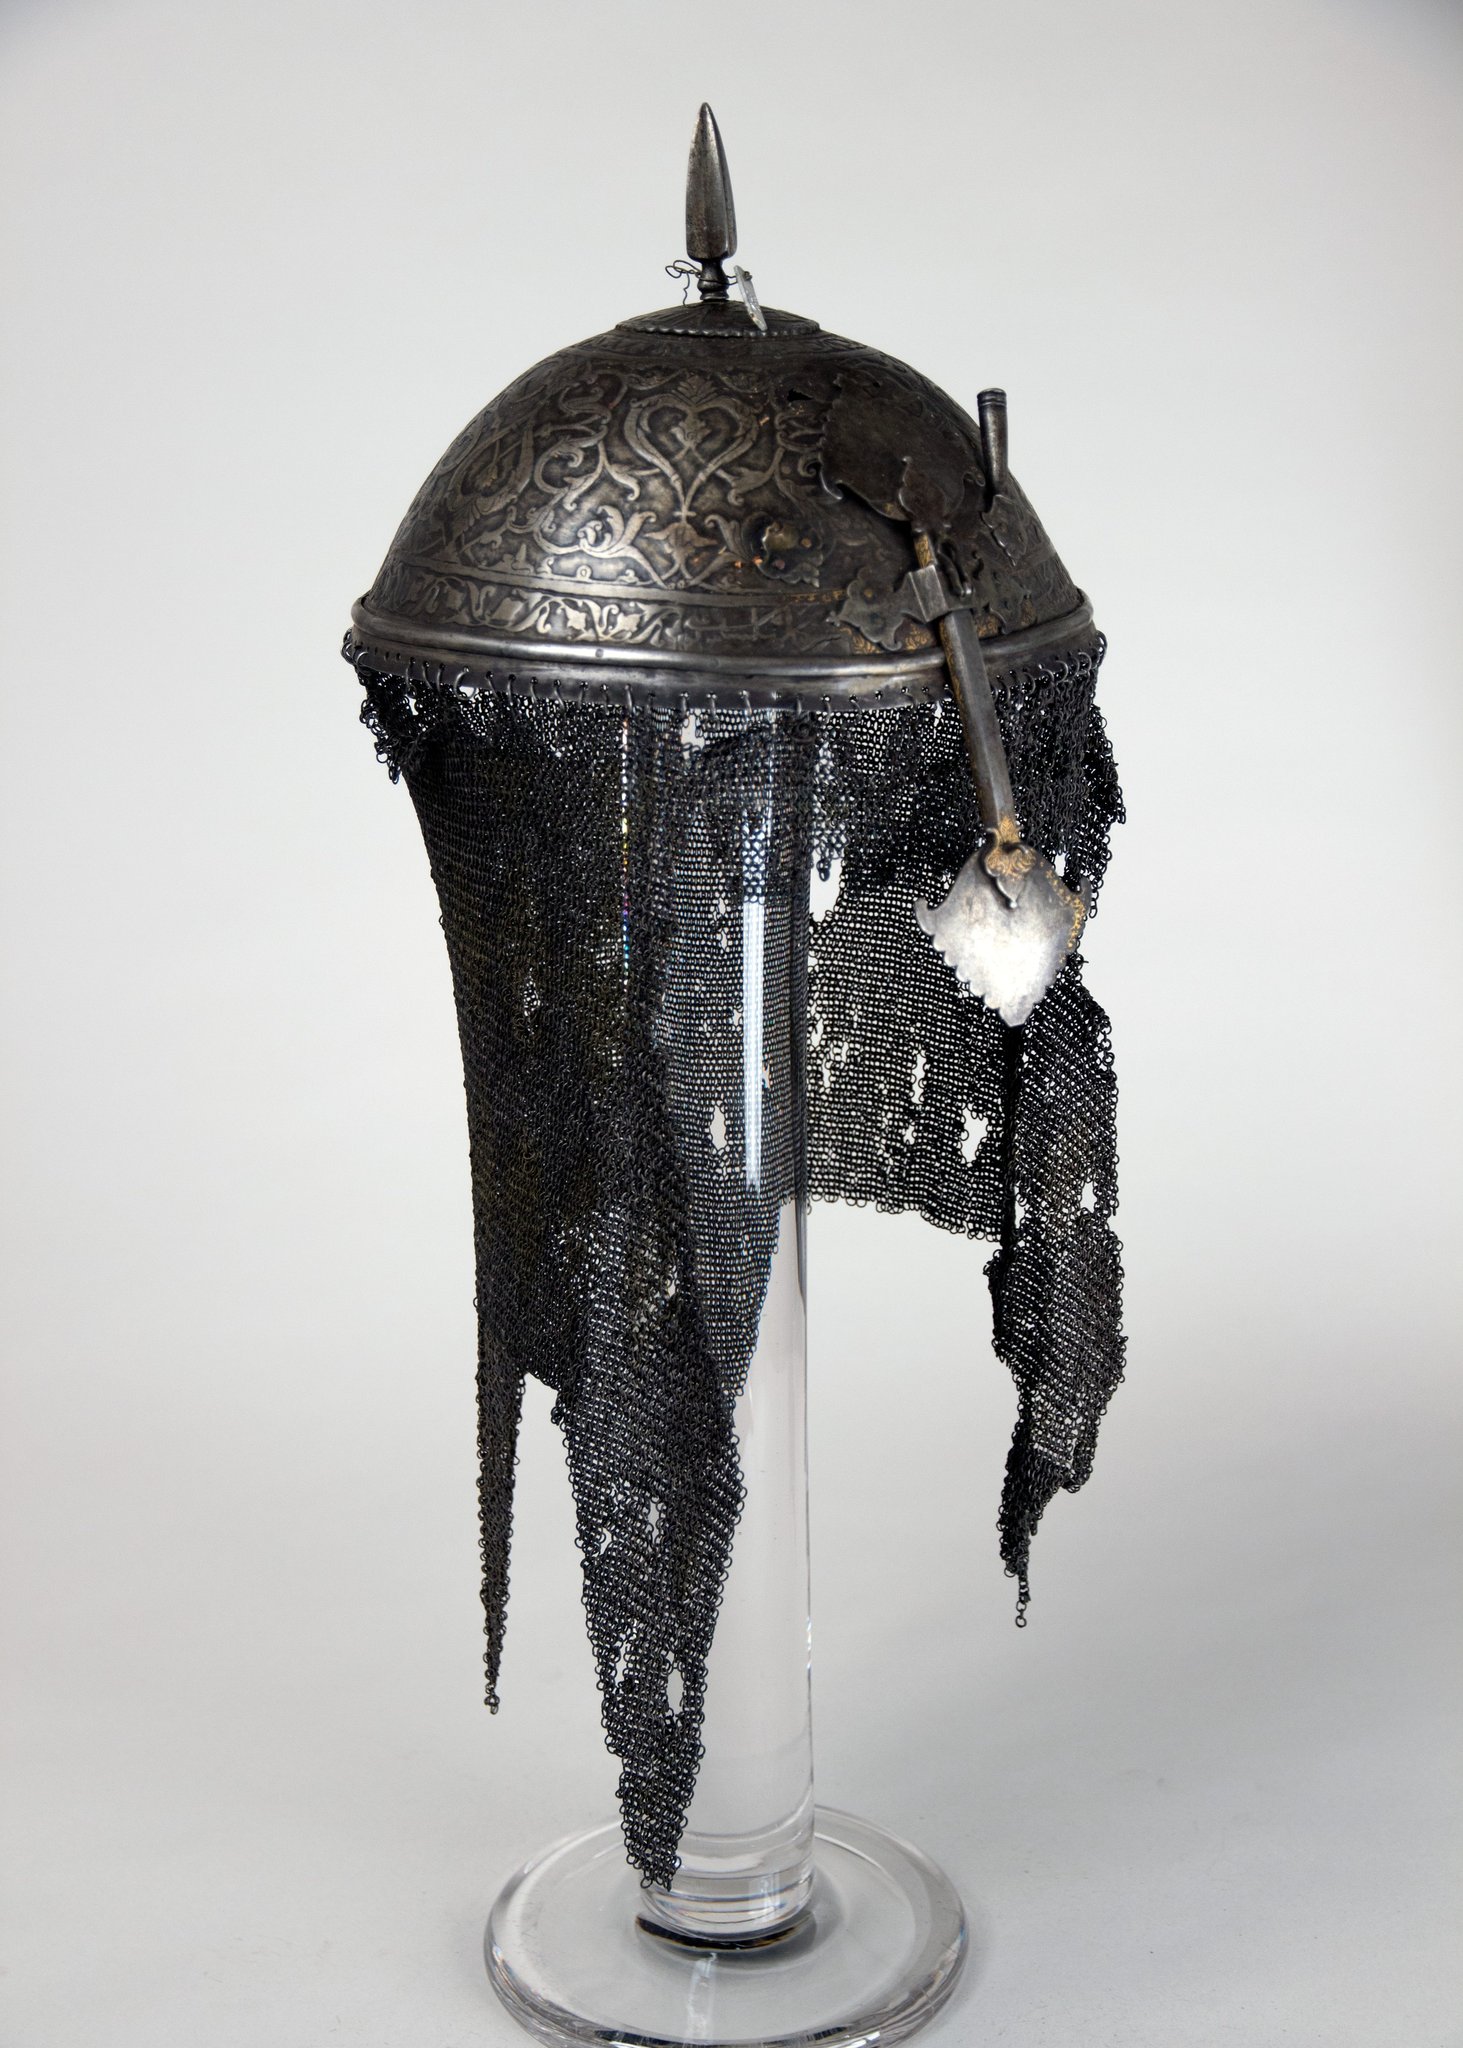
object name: helmet and cuirass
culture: indian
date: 1701-1900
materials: steel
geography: china